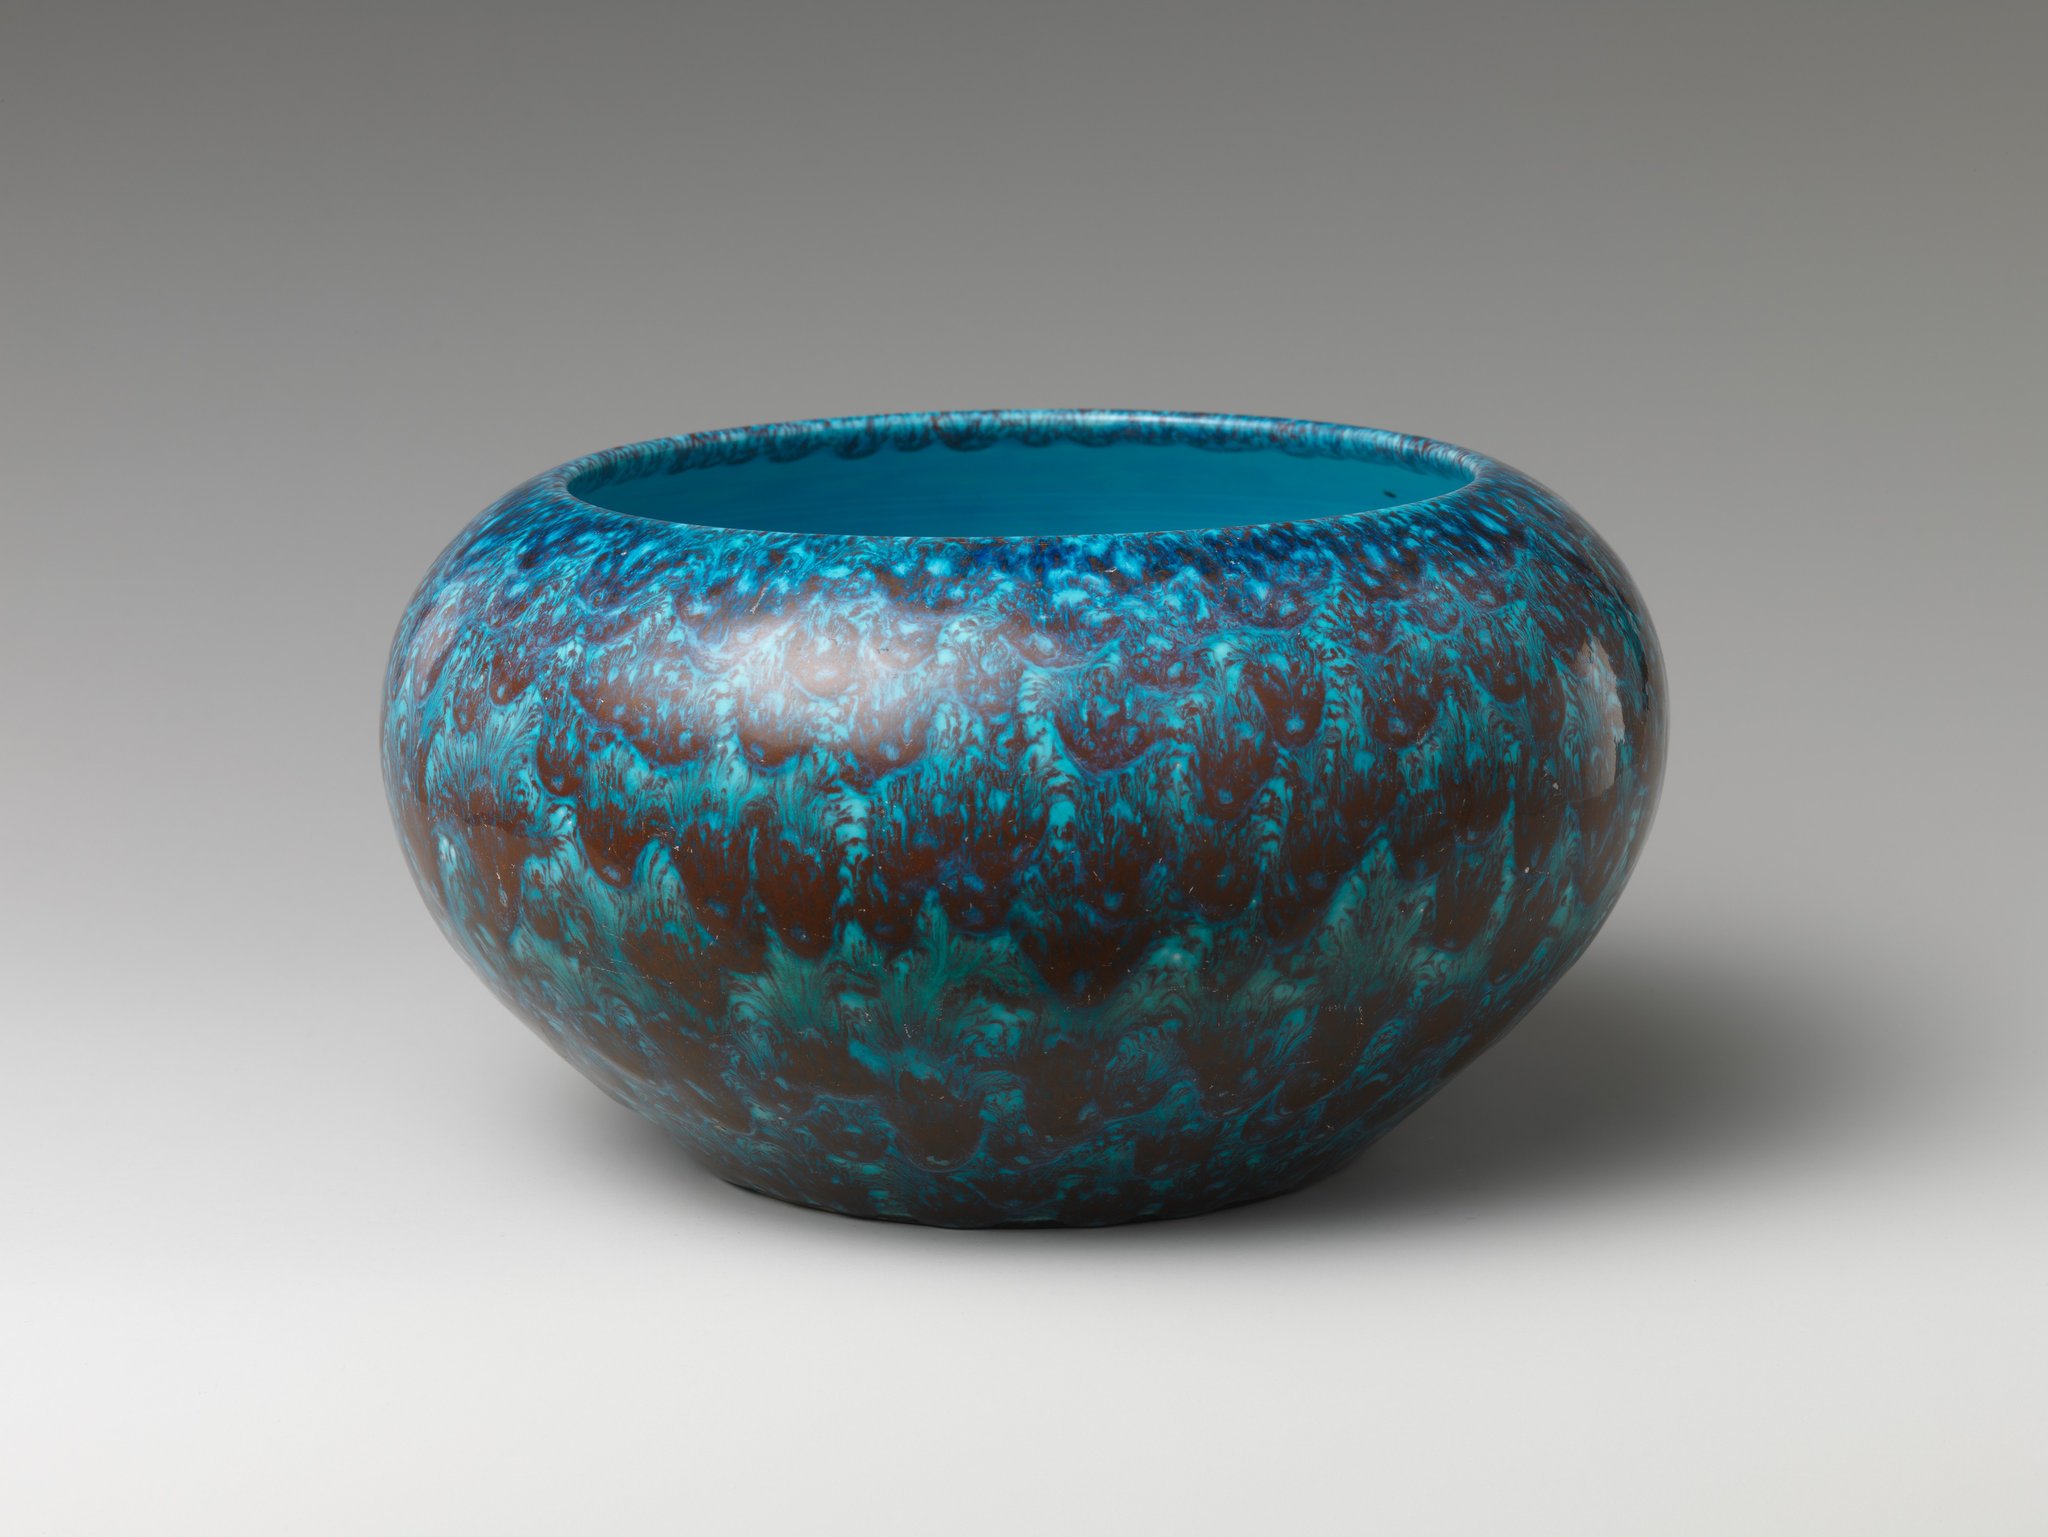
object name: bowl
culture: chinese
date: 1701-1733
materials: feather, glaze, porcelain